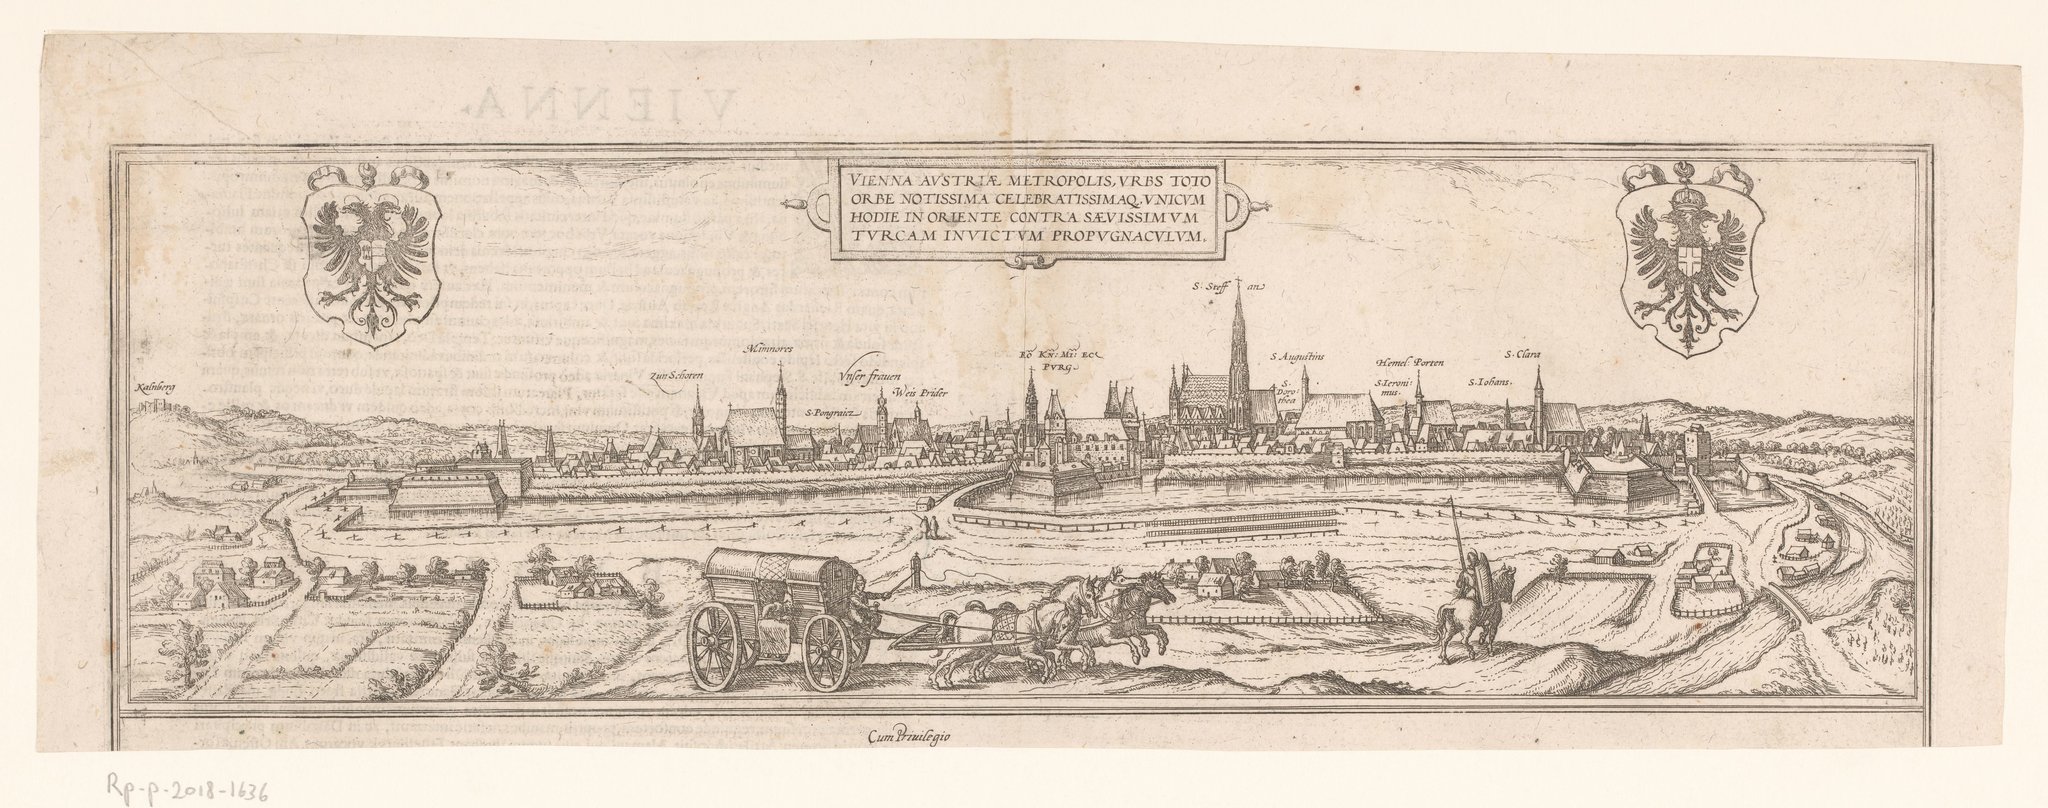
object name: print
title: Vienna Austriae metropolis, urbs toto orbe notissima (...)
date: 1572-1575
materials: paper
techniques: engraving, etching, letterpress printing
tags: coat of arms (as symbol of the state, etc.) (+ city; municipal), coat of arms (as symbol of the state, etc.) (+ province; provincial), prospect of city, town panorama, silhouette of city, vienna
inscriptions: collector's mark: Lugt 2228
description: Prent is gedrukt van dezelfde plaat als een gezicht op Budapest, maar is hiervan afgesneden. Het blad met deze twee prenten is vanaf 1572 gebruikt in Braun & Hogenbergs 'Civitates Orbis Terrarum'. Zie ook: RP-P-2018-1839.